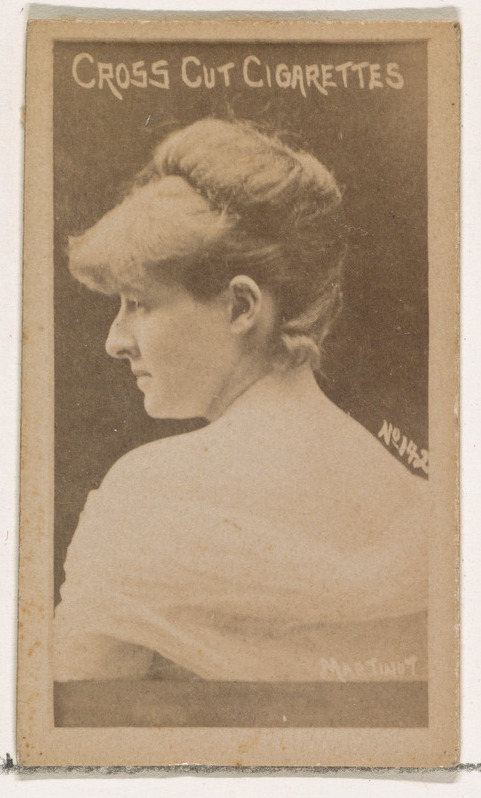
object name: print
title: Card Number 142, Sadie Martinot, from the Actors and Actresses series (N145-1) issued by Duke Sons & Co. to promote Cross Cut Cigarettes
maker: w. duke, sons & co.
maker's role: publisher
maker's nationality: american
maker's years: 1870-1920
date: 1880-1889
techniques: albumen silver print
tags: women,actresses